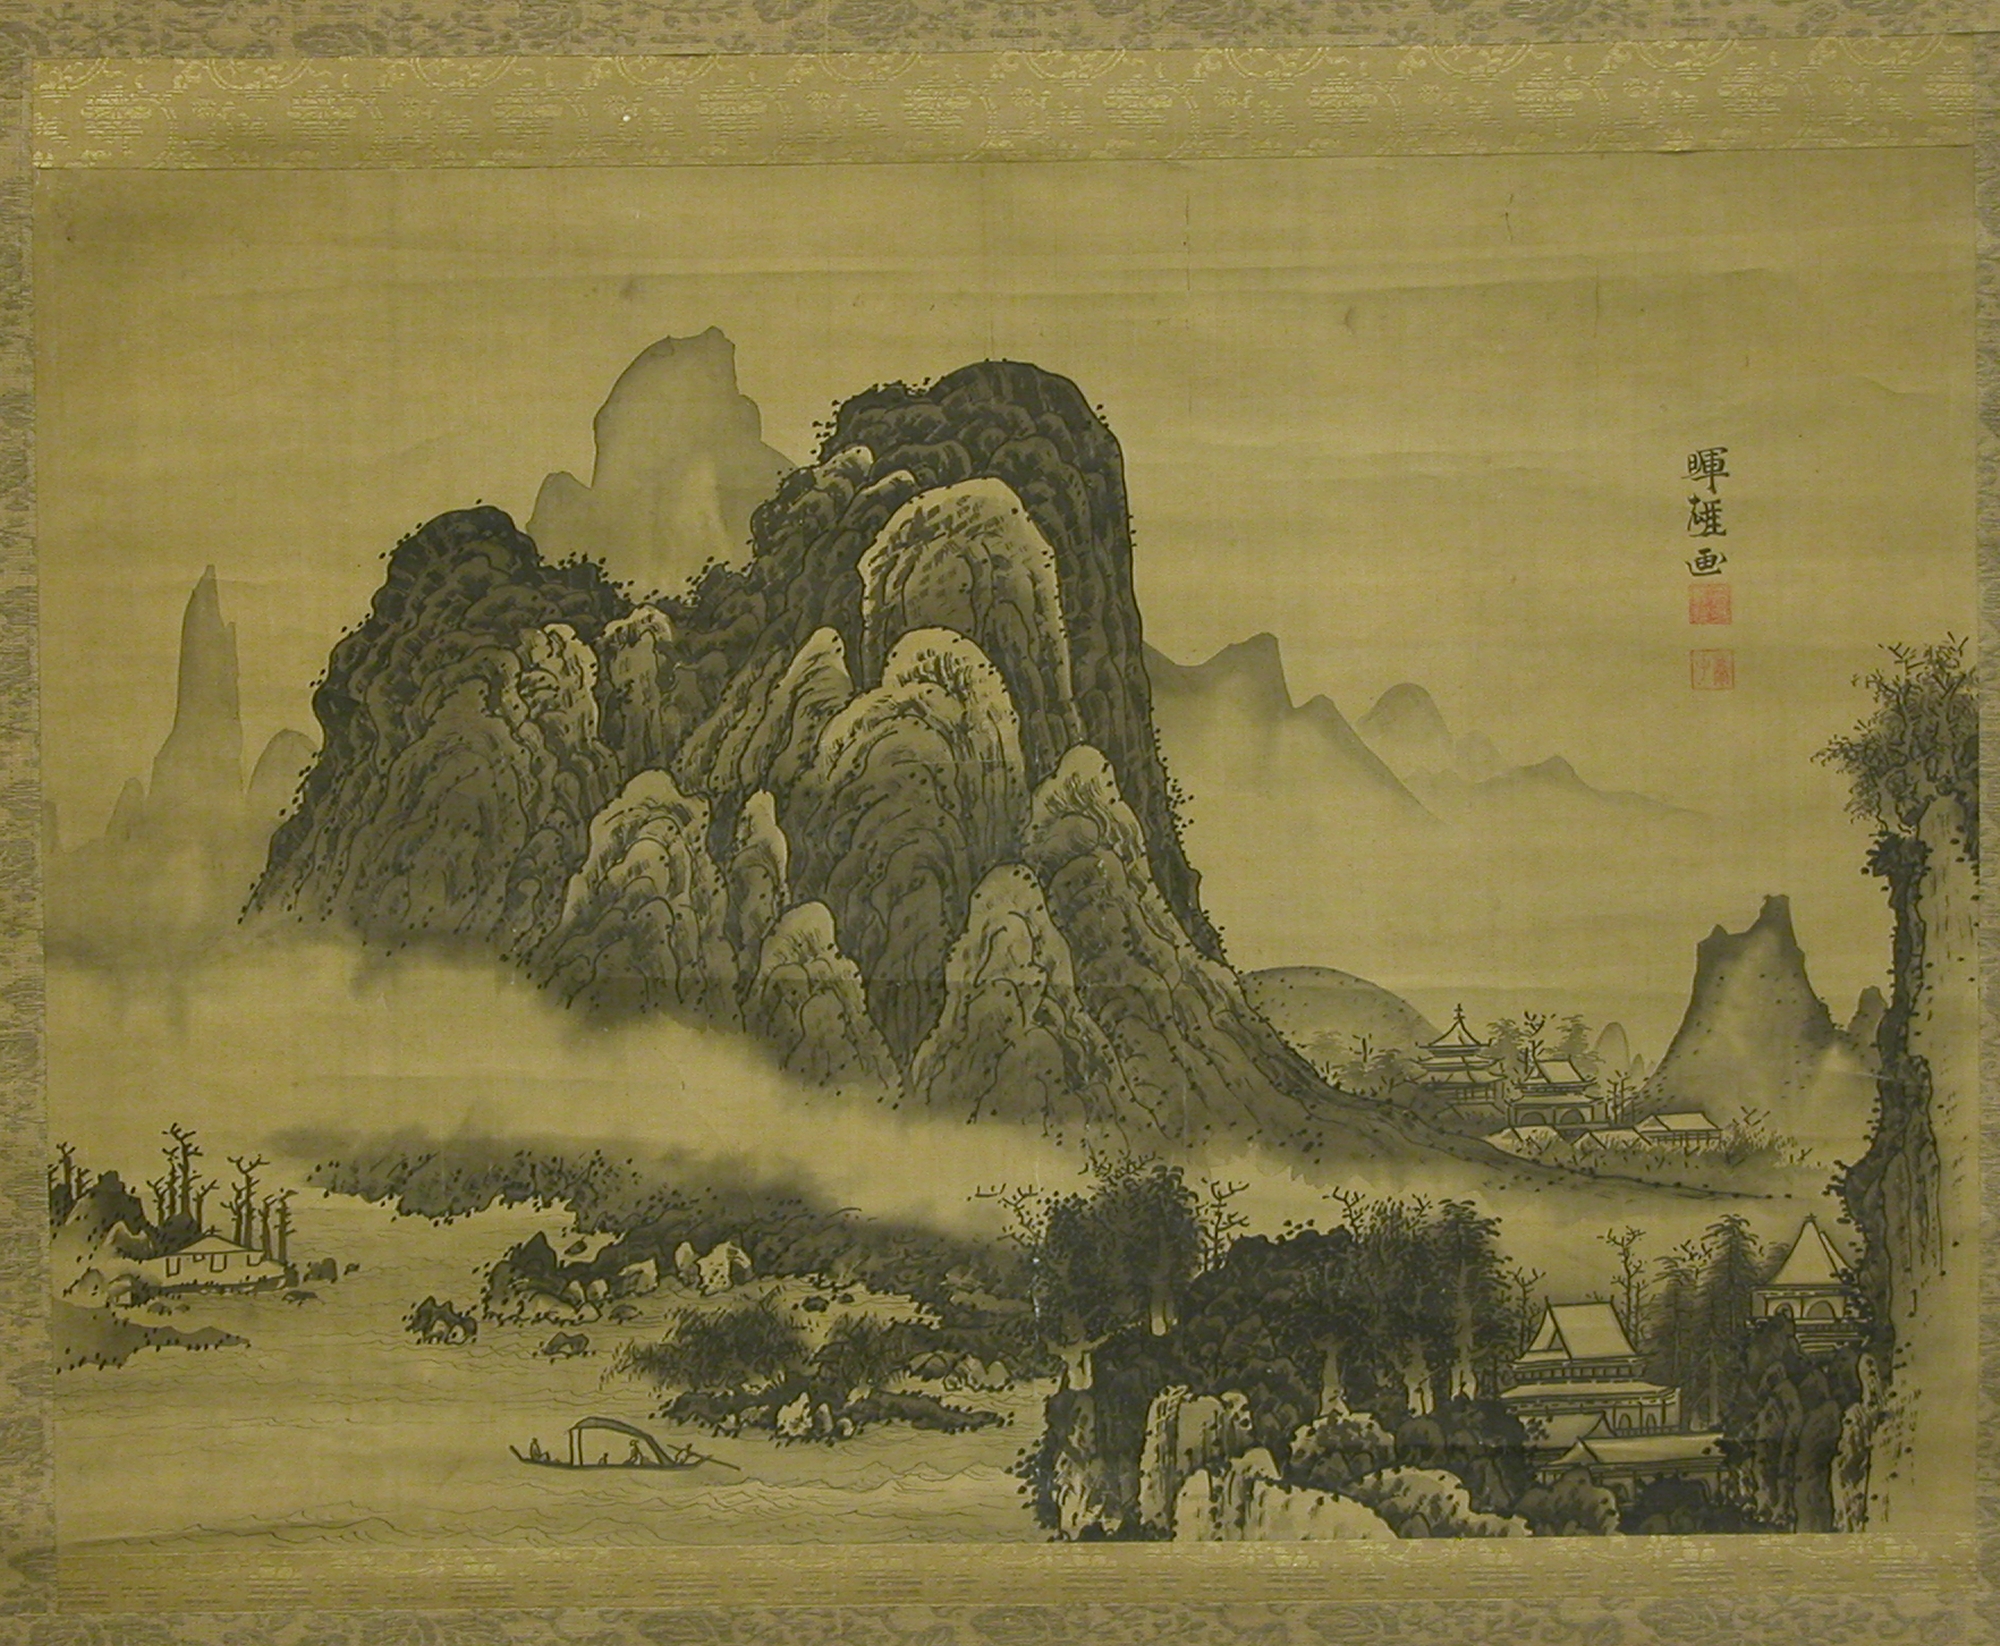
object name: hanging scroll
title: Mountain Landscape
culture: japanese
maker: soga shōhaku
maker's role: artist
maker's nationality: japanese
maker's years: 1730-1781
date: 1761-1763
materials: ink, silk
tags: mountains,landscapes